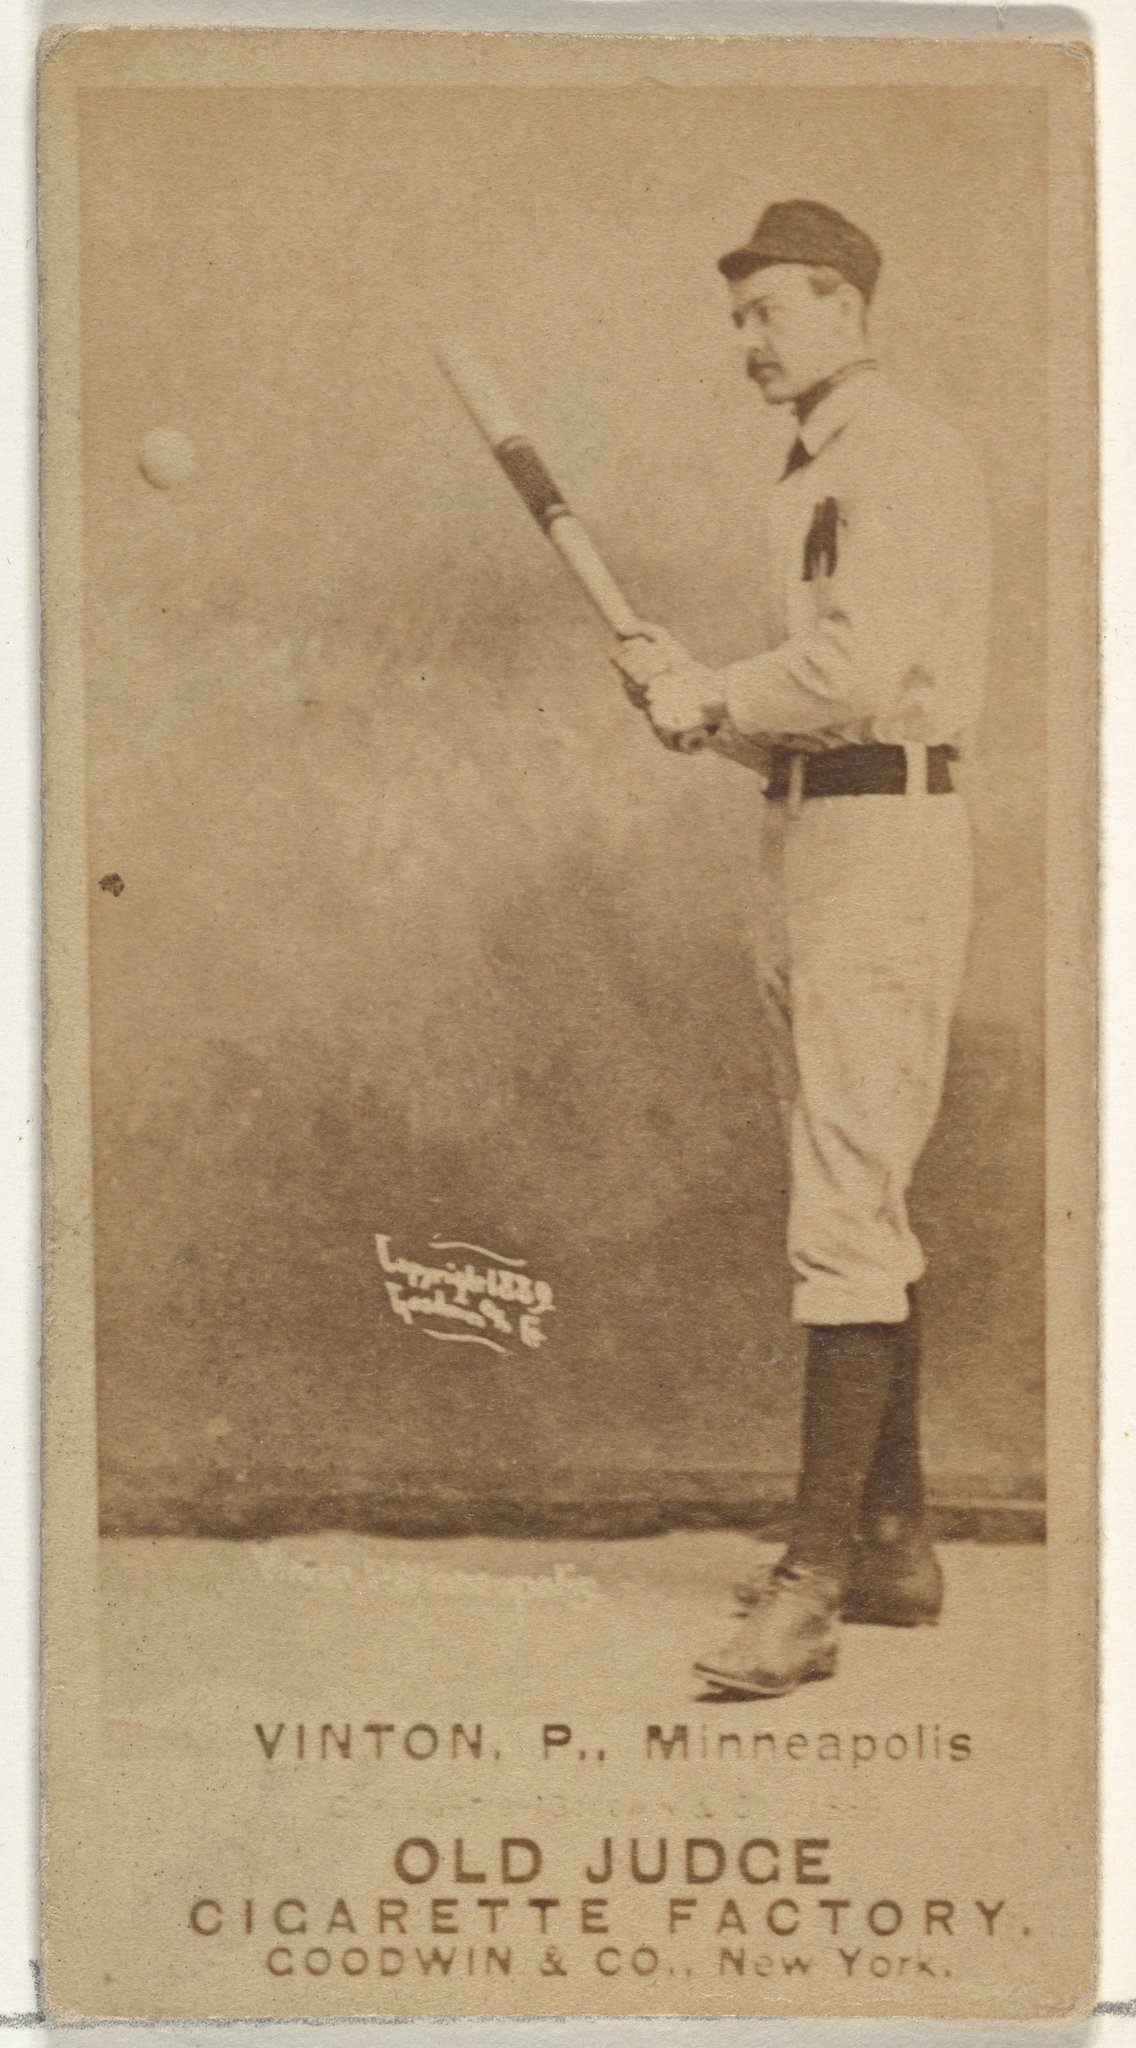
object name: baseball card, photograph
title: William Miller "Bill" Vinton, Pitcher, Minneapolis, from the Old Judge series (N172) for Old Judge Cigarettes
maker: goodwin & company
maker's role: publisher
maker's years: 1850-1950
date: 1889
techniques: albumen silver print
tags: men,portraits,baseball,athletes